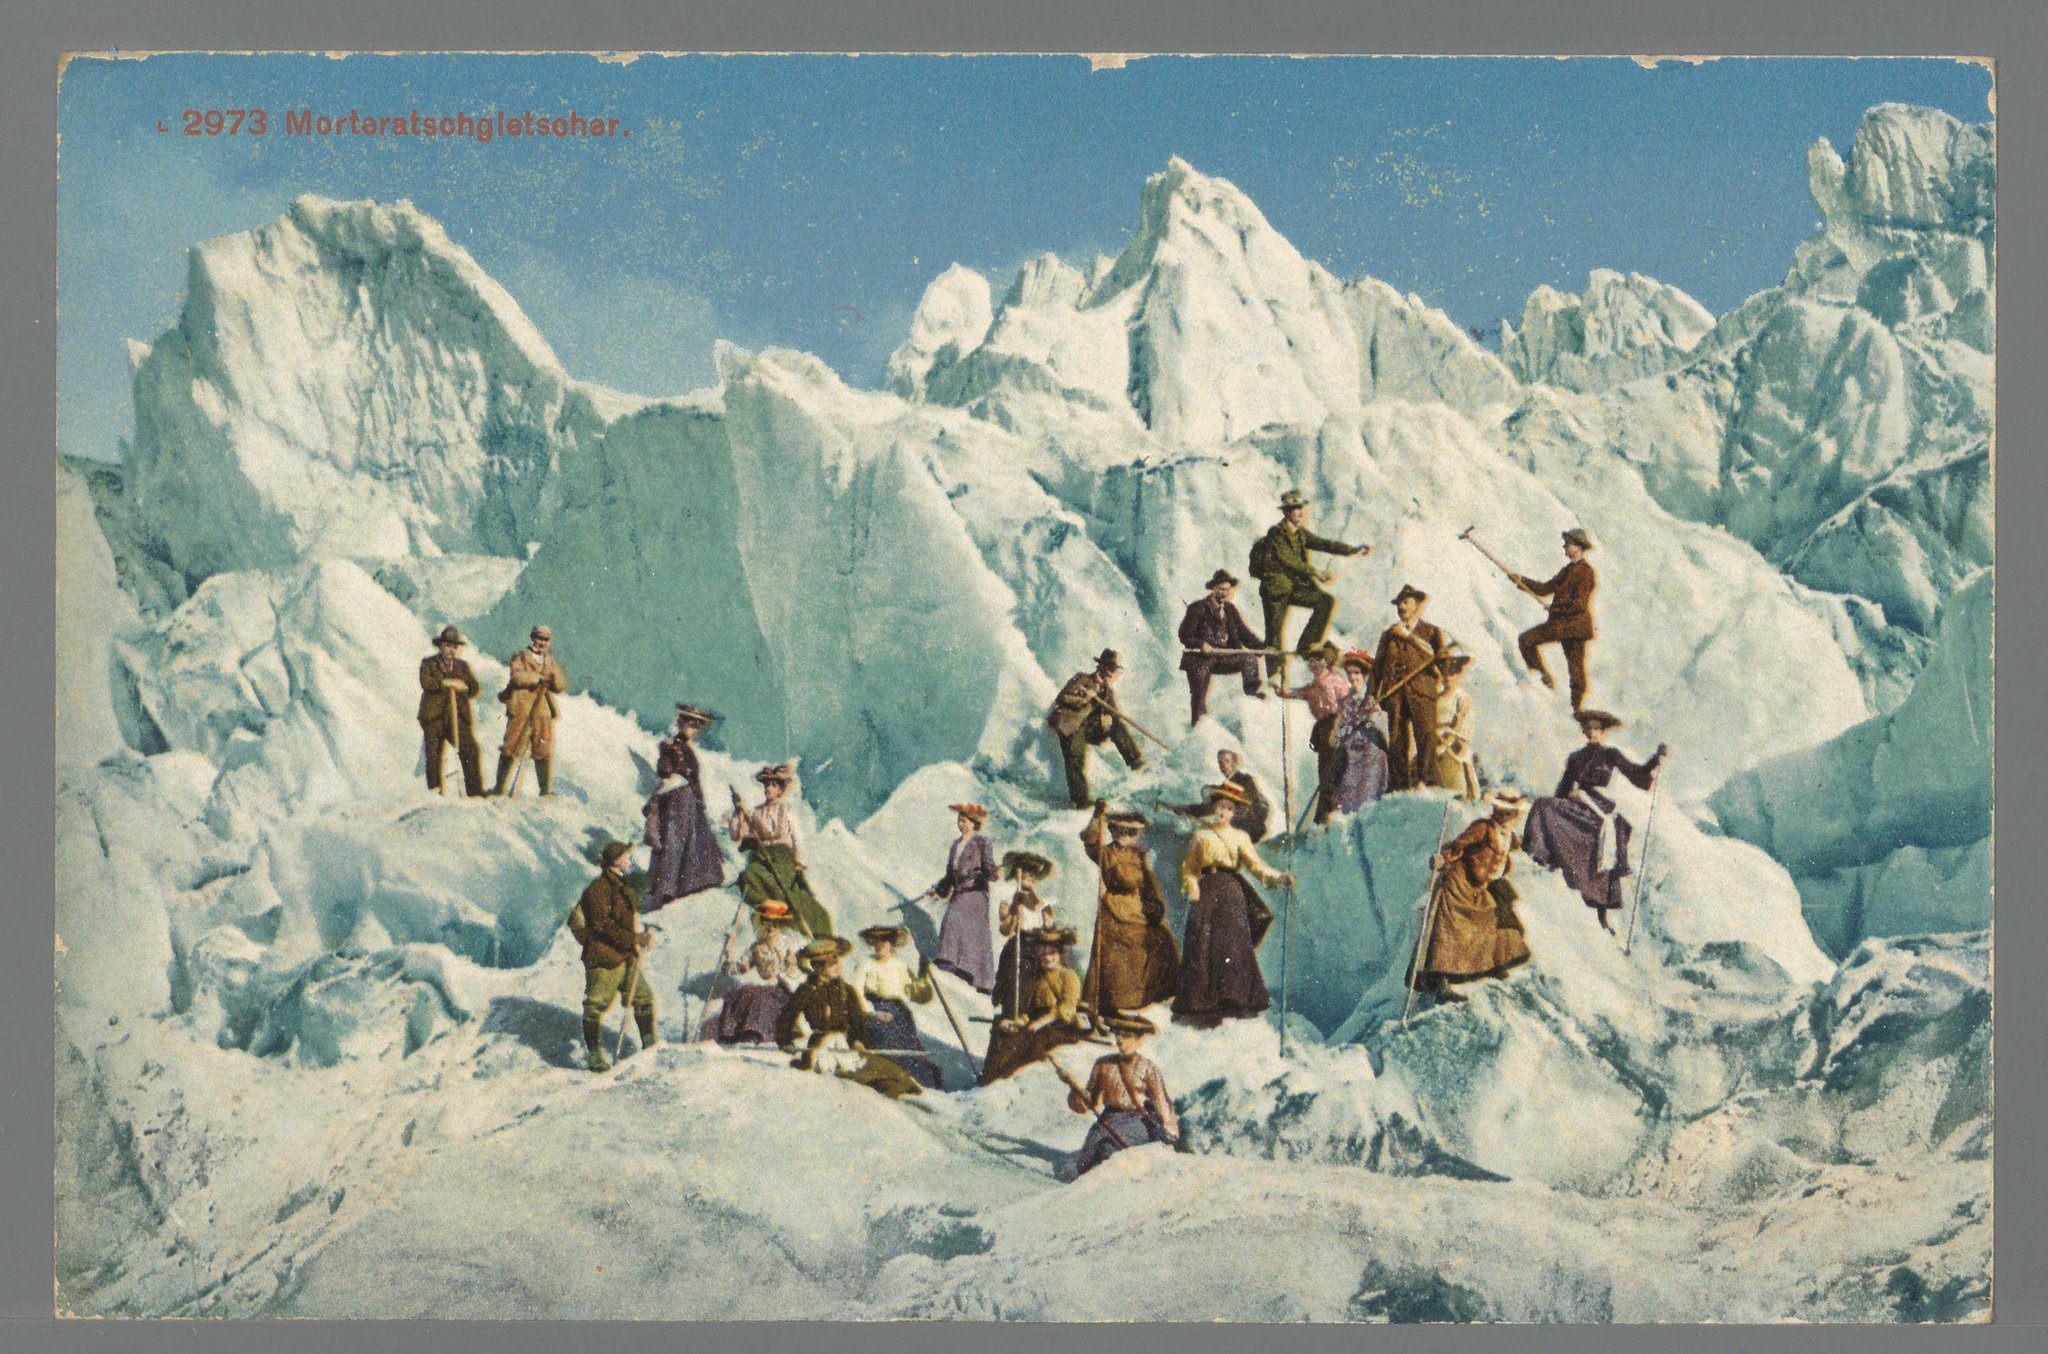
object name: photomechanical print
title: Morteratschgletscher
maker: Anonymous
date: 1905-1920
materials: cardboard, photographic process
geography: zurich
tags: glacier (+ landscape with figures, staffage)